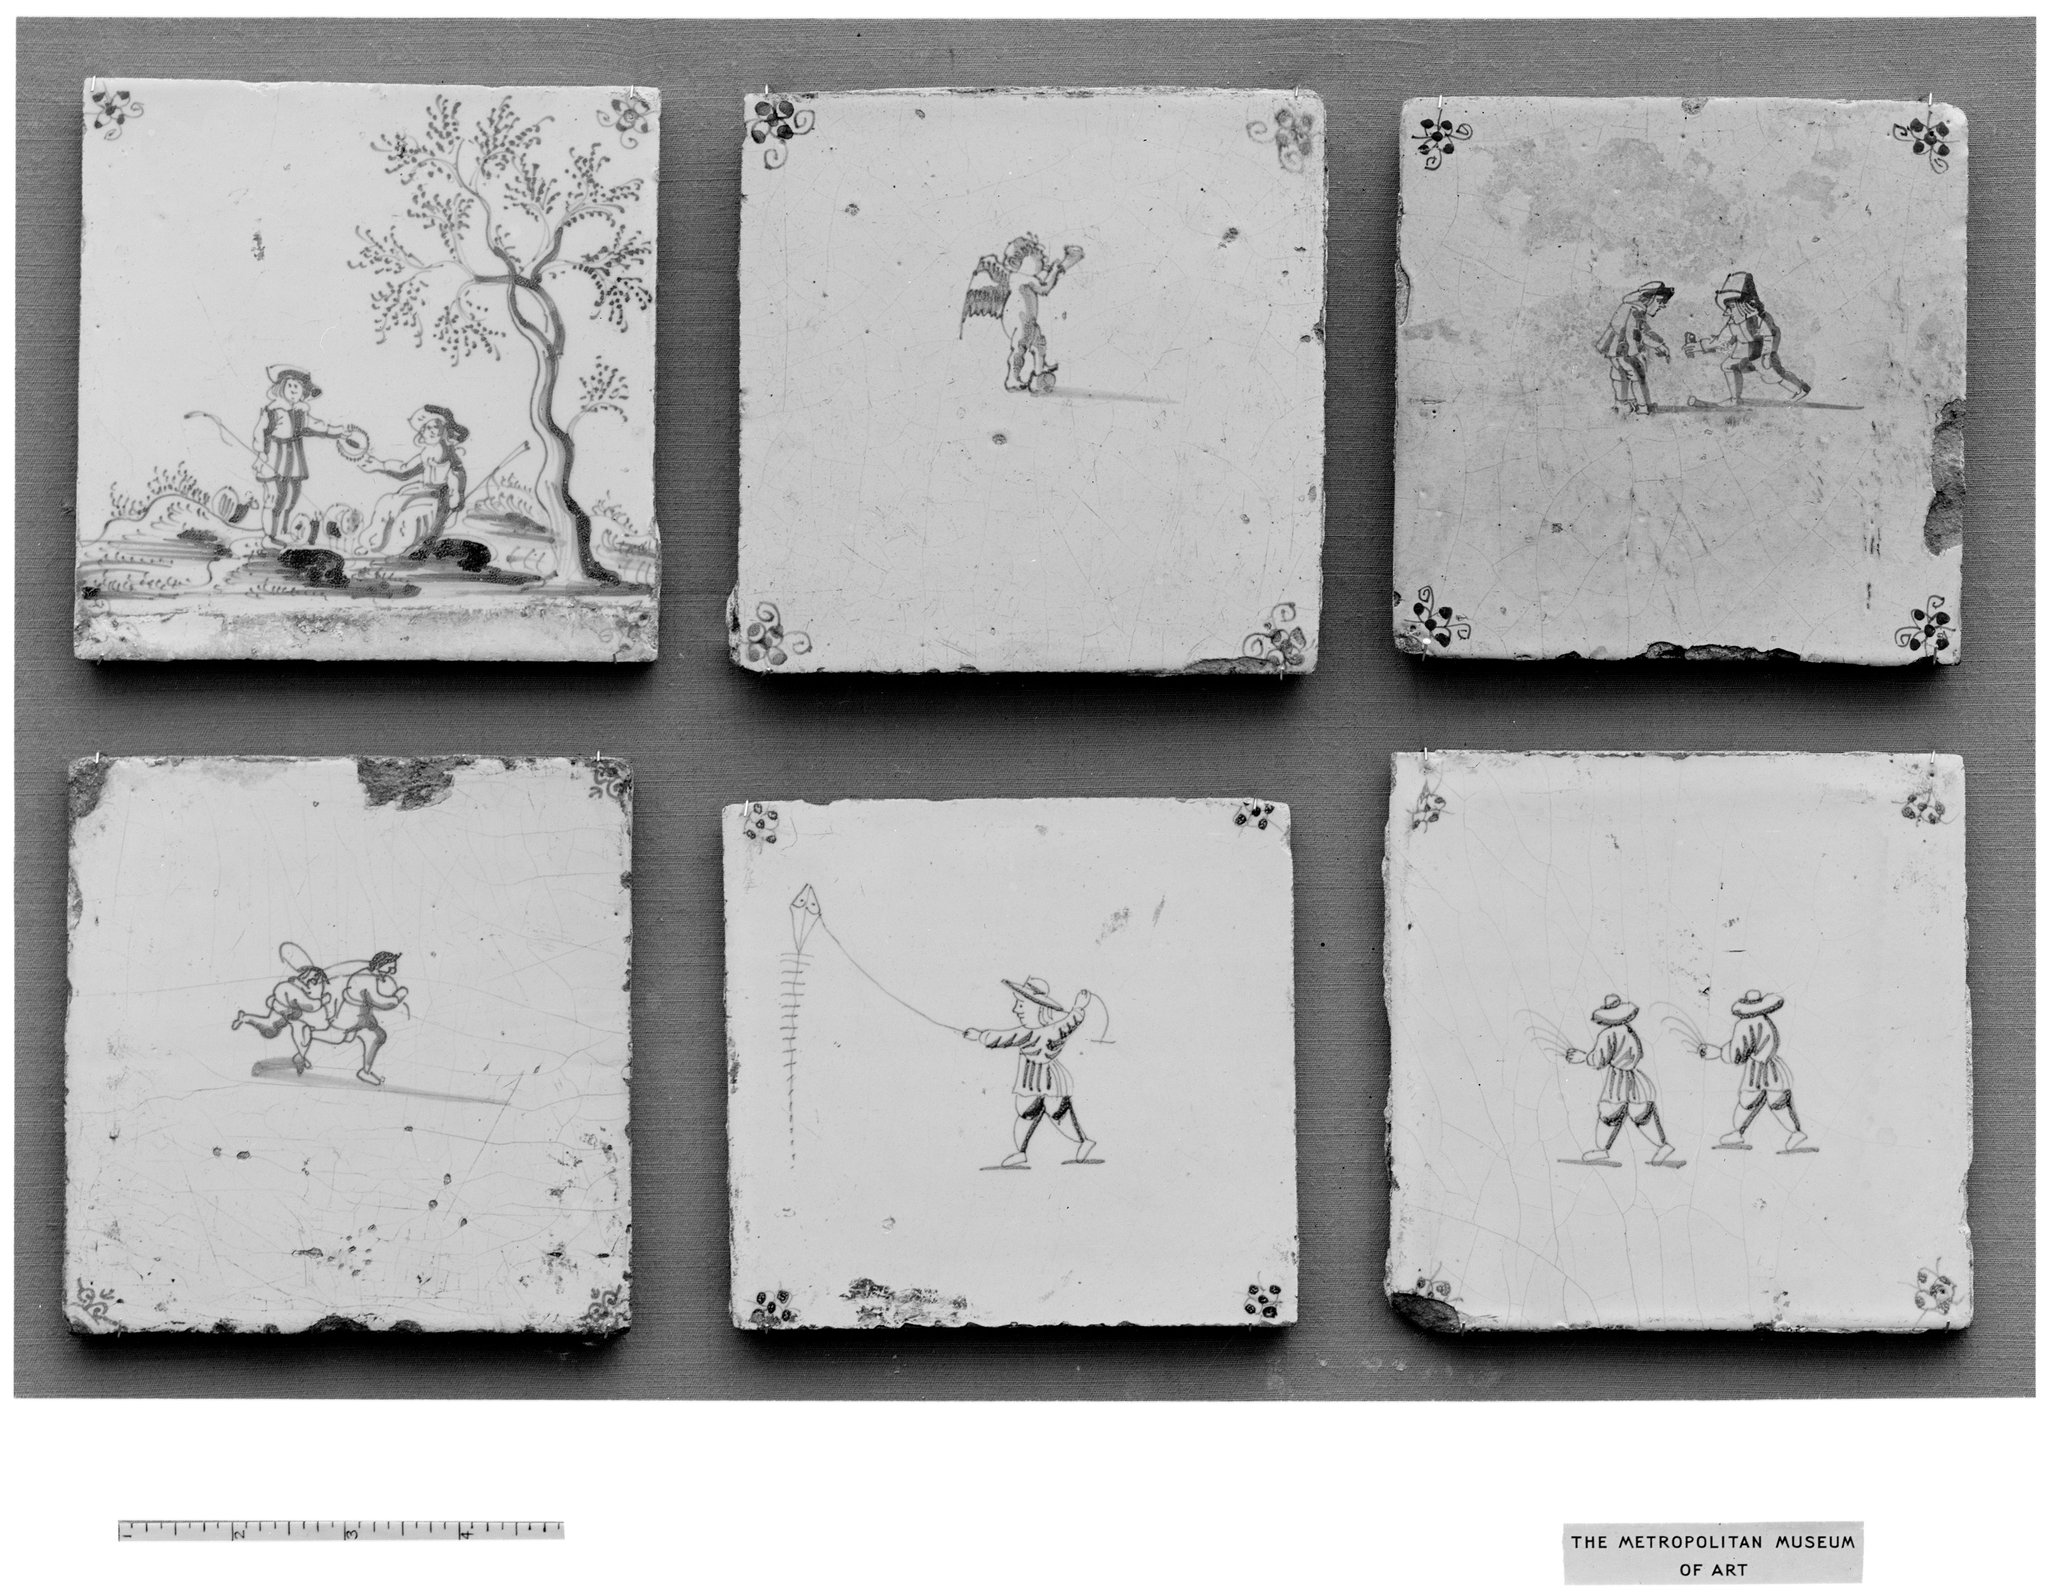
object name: tile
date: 1701-1800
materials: earthenware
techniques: glazing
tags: men,women,trees